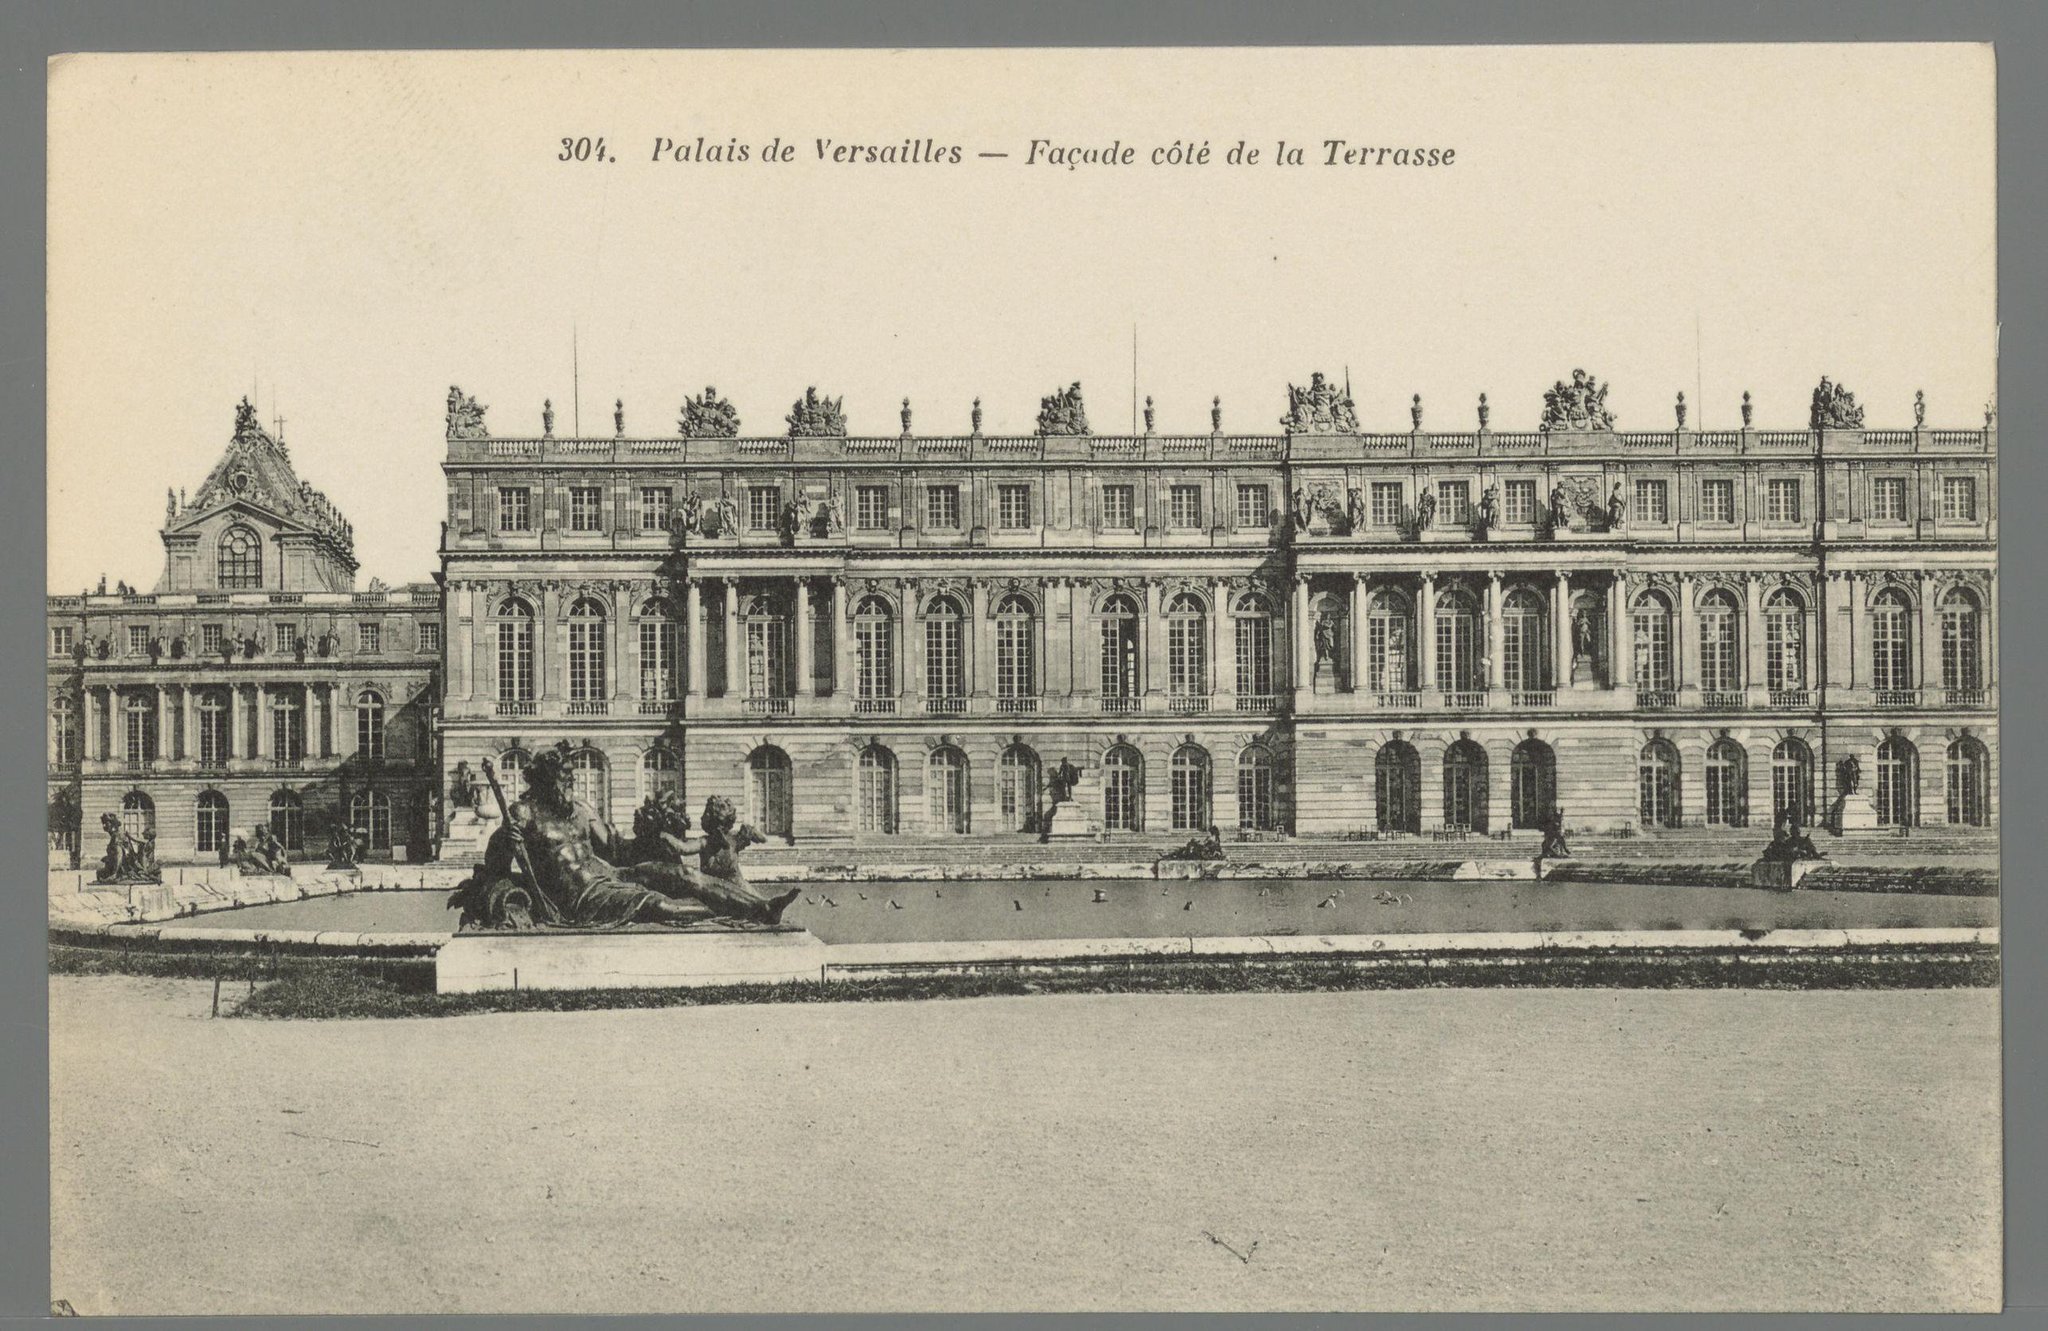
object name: photomechanical print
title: Palais de Versailles. Façade côté de la Terrasse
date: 1903-1920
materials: cardboard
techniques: photograph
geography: versailles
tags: palace, exterior ~ representation of a building, garden pond